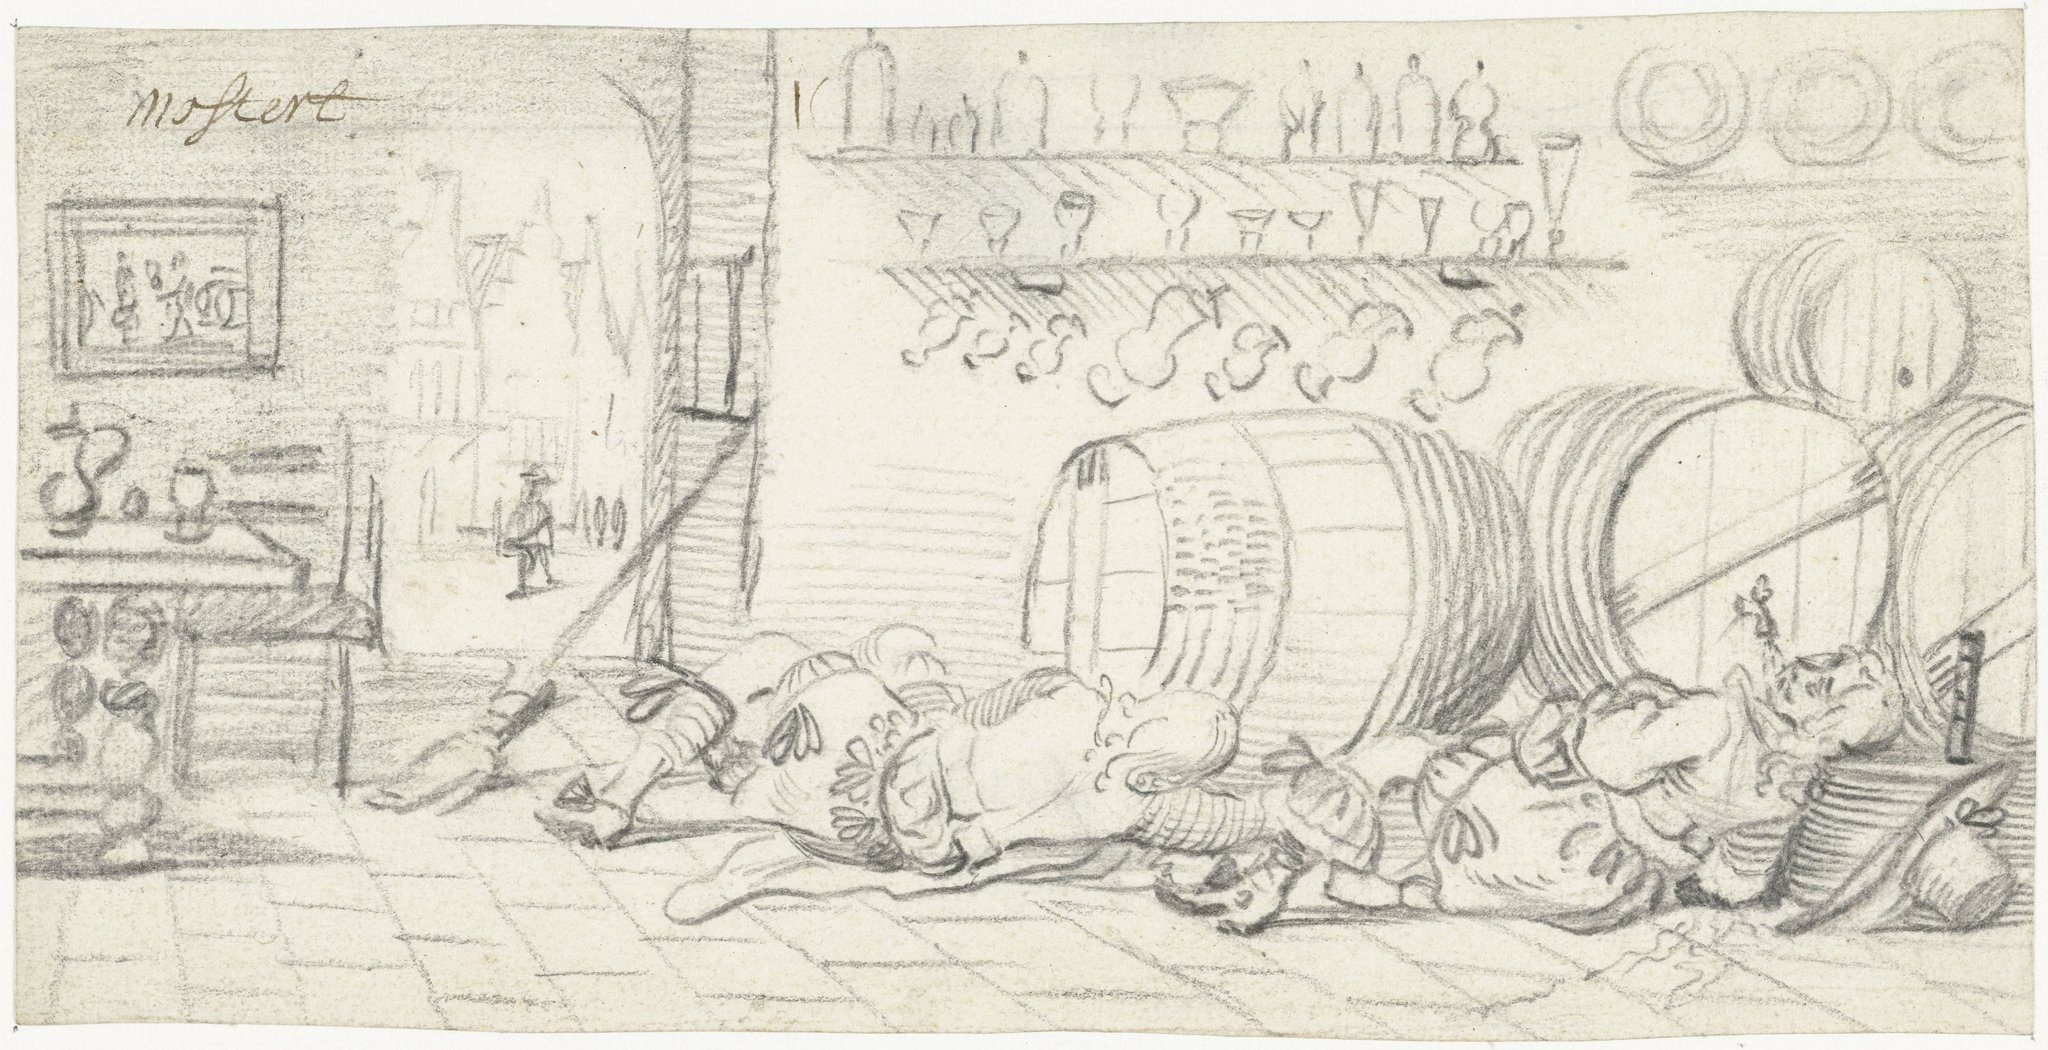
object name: drawing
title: Dronkaards liggend in een taveerne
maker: gesina ter borch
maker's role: draughtsman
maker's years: 1633-1690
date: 1658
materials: paper, pencil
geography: zwolle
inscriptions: inscription: ‘Mostert’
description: Het opschrift Mostert refereert aan de melodie La Mostarde Nouvelle van het drinklied dat Gesina kopieerde op folio 84 van het Poëziealbum.